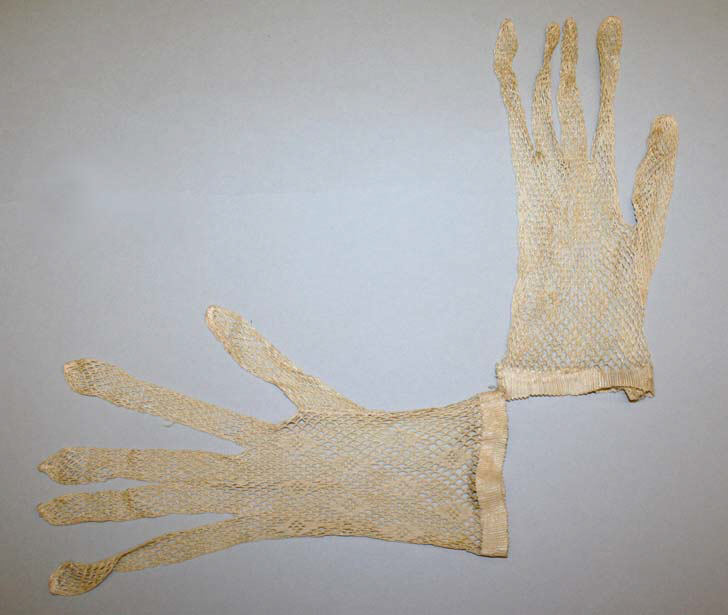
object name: glove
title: Gloves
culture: american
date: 1825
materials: silk